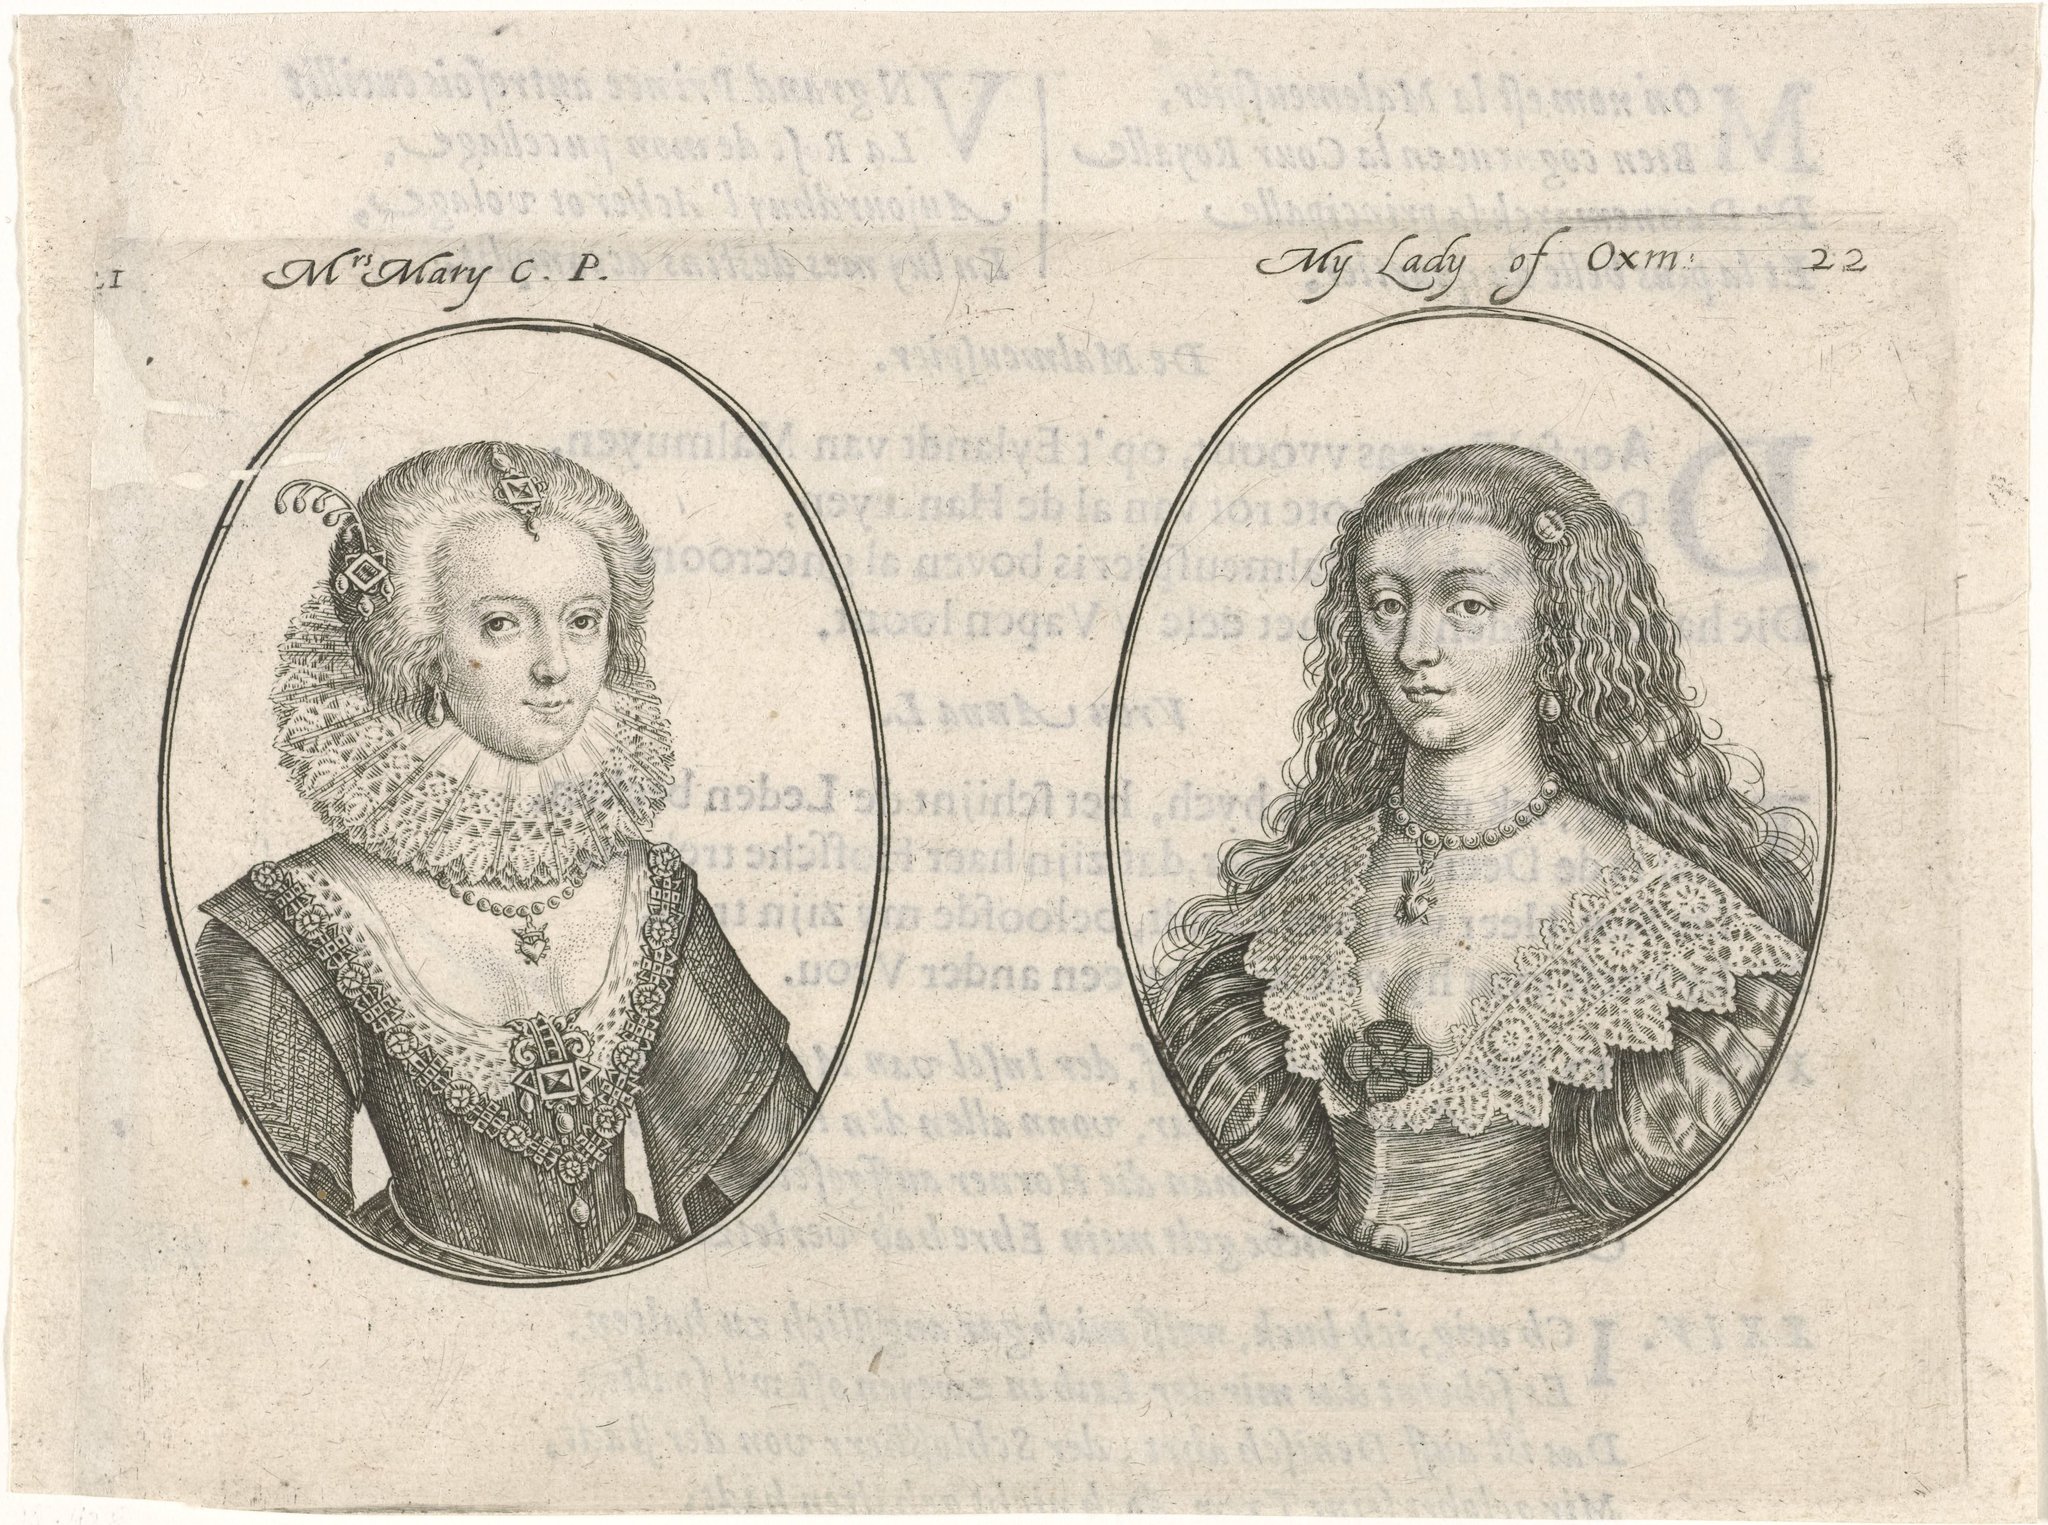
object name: book illustration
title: Portretten van twee courtisanes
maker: crispijn van de passe (ii)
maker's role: draughtsman, print maker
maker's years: 1594-1670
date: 1630-1632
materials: paper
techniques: engraving, letterpress printing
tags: whore, prostitute - cc - male prostitution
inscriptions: collector's mark: Lugt 2228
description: Prent gemaakt voor: Le miroir des courtisannes de ce temps. Verschillende edities van dit werk, uitgegeven tussen 1630 en 1710, maken gebruik van de gravures van Van der Passe óf van spiegelbeeldige kopieën ervan.